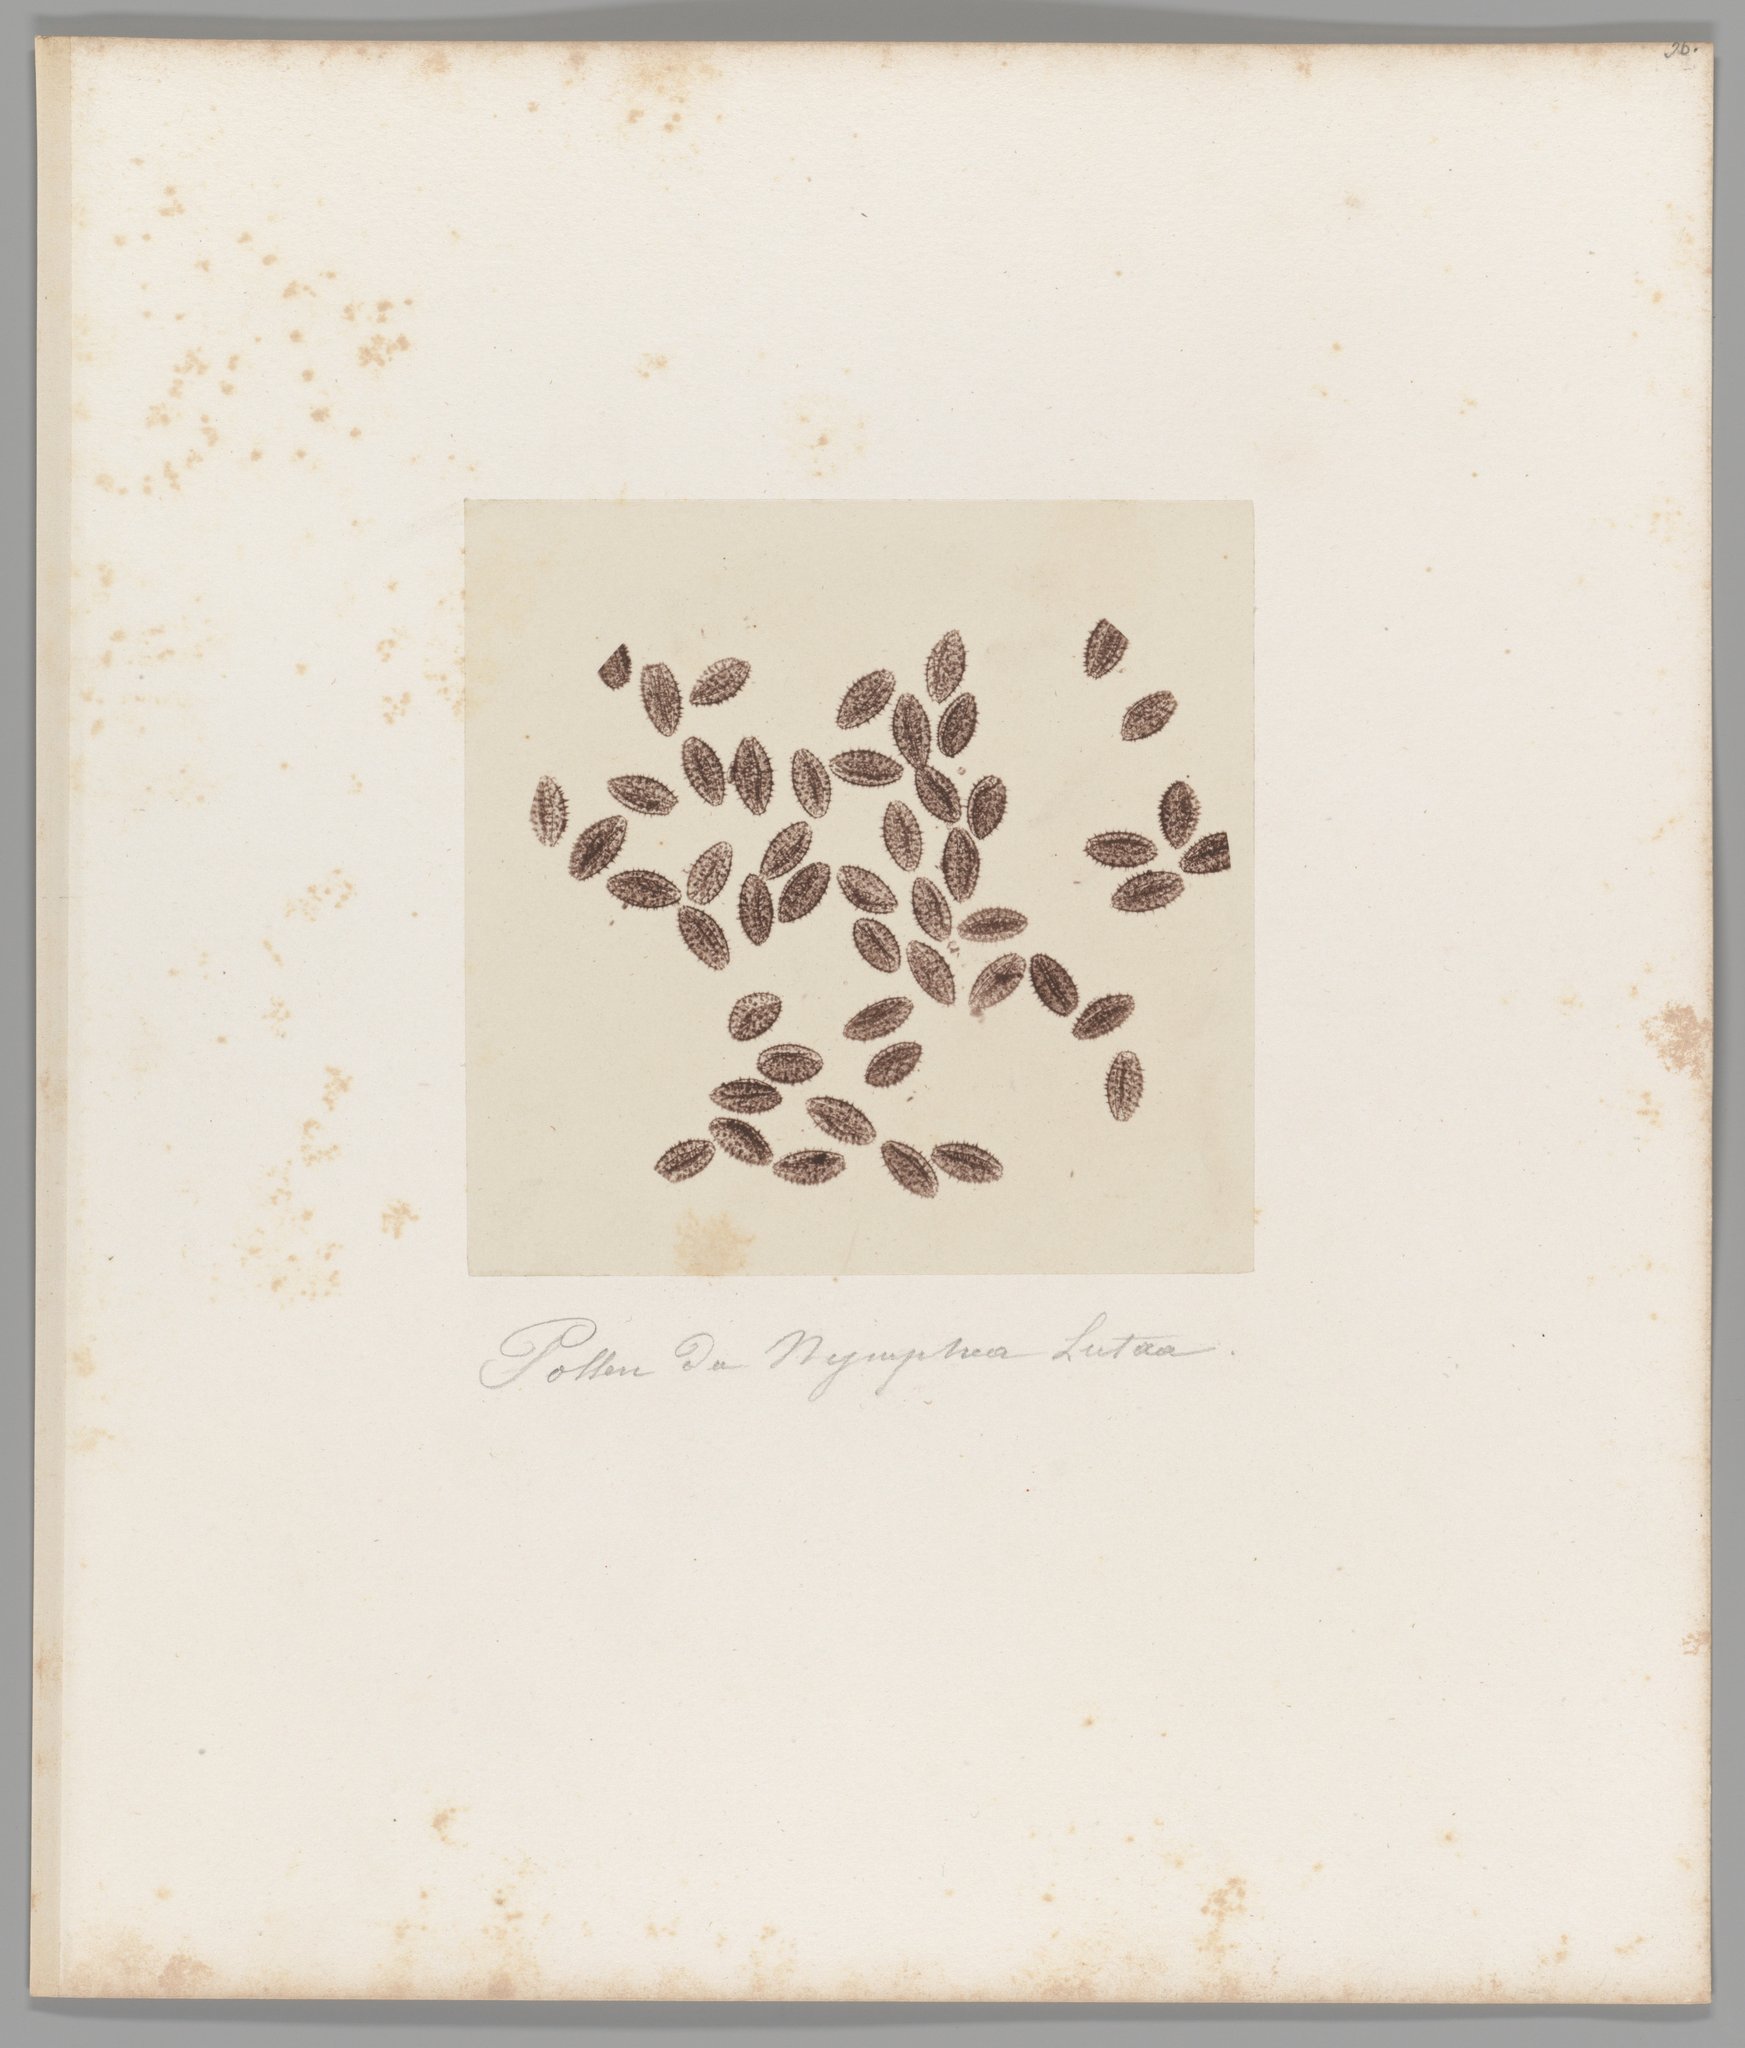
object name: photograph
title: [Untitled]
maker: auguste-adolphe bertsch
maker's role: artist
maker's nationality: french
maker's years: 1813-1871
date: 1853-1857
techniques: salted paper print